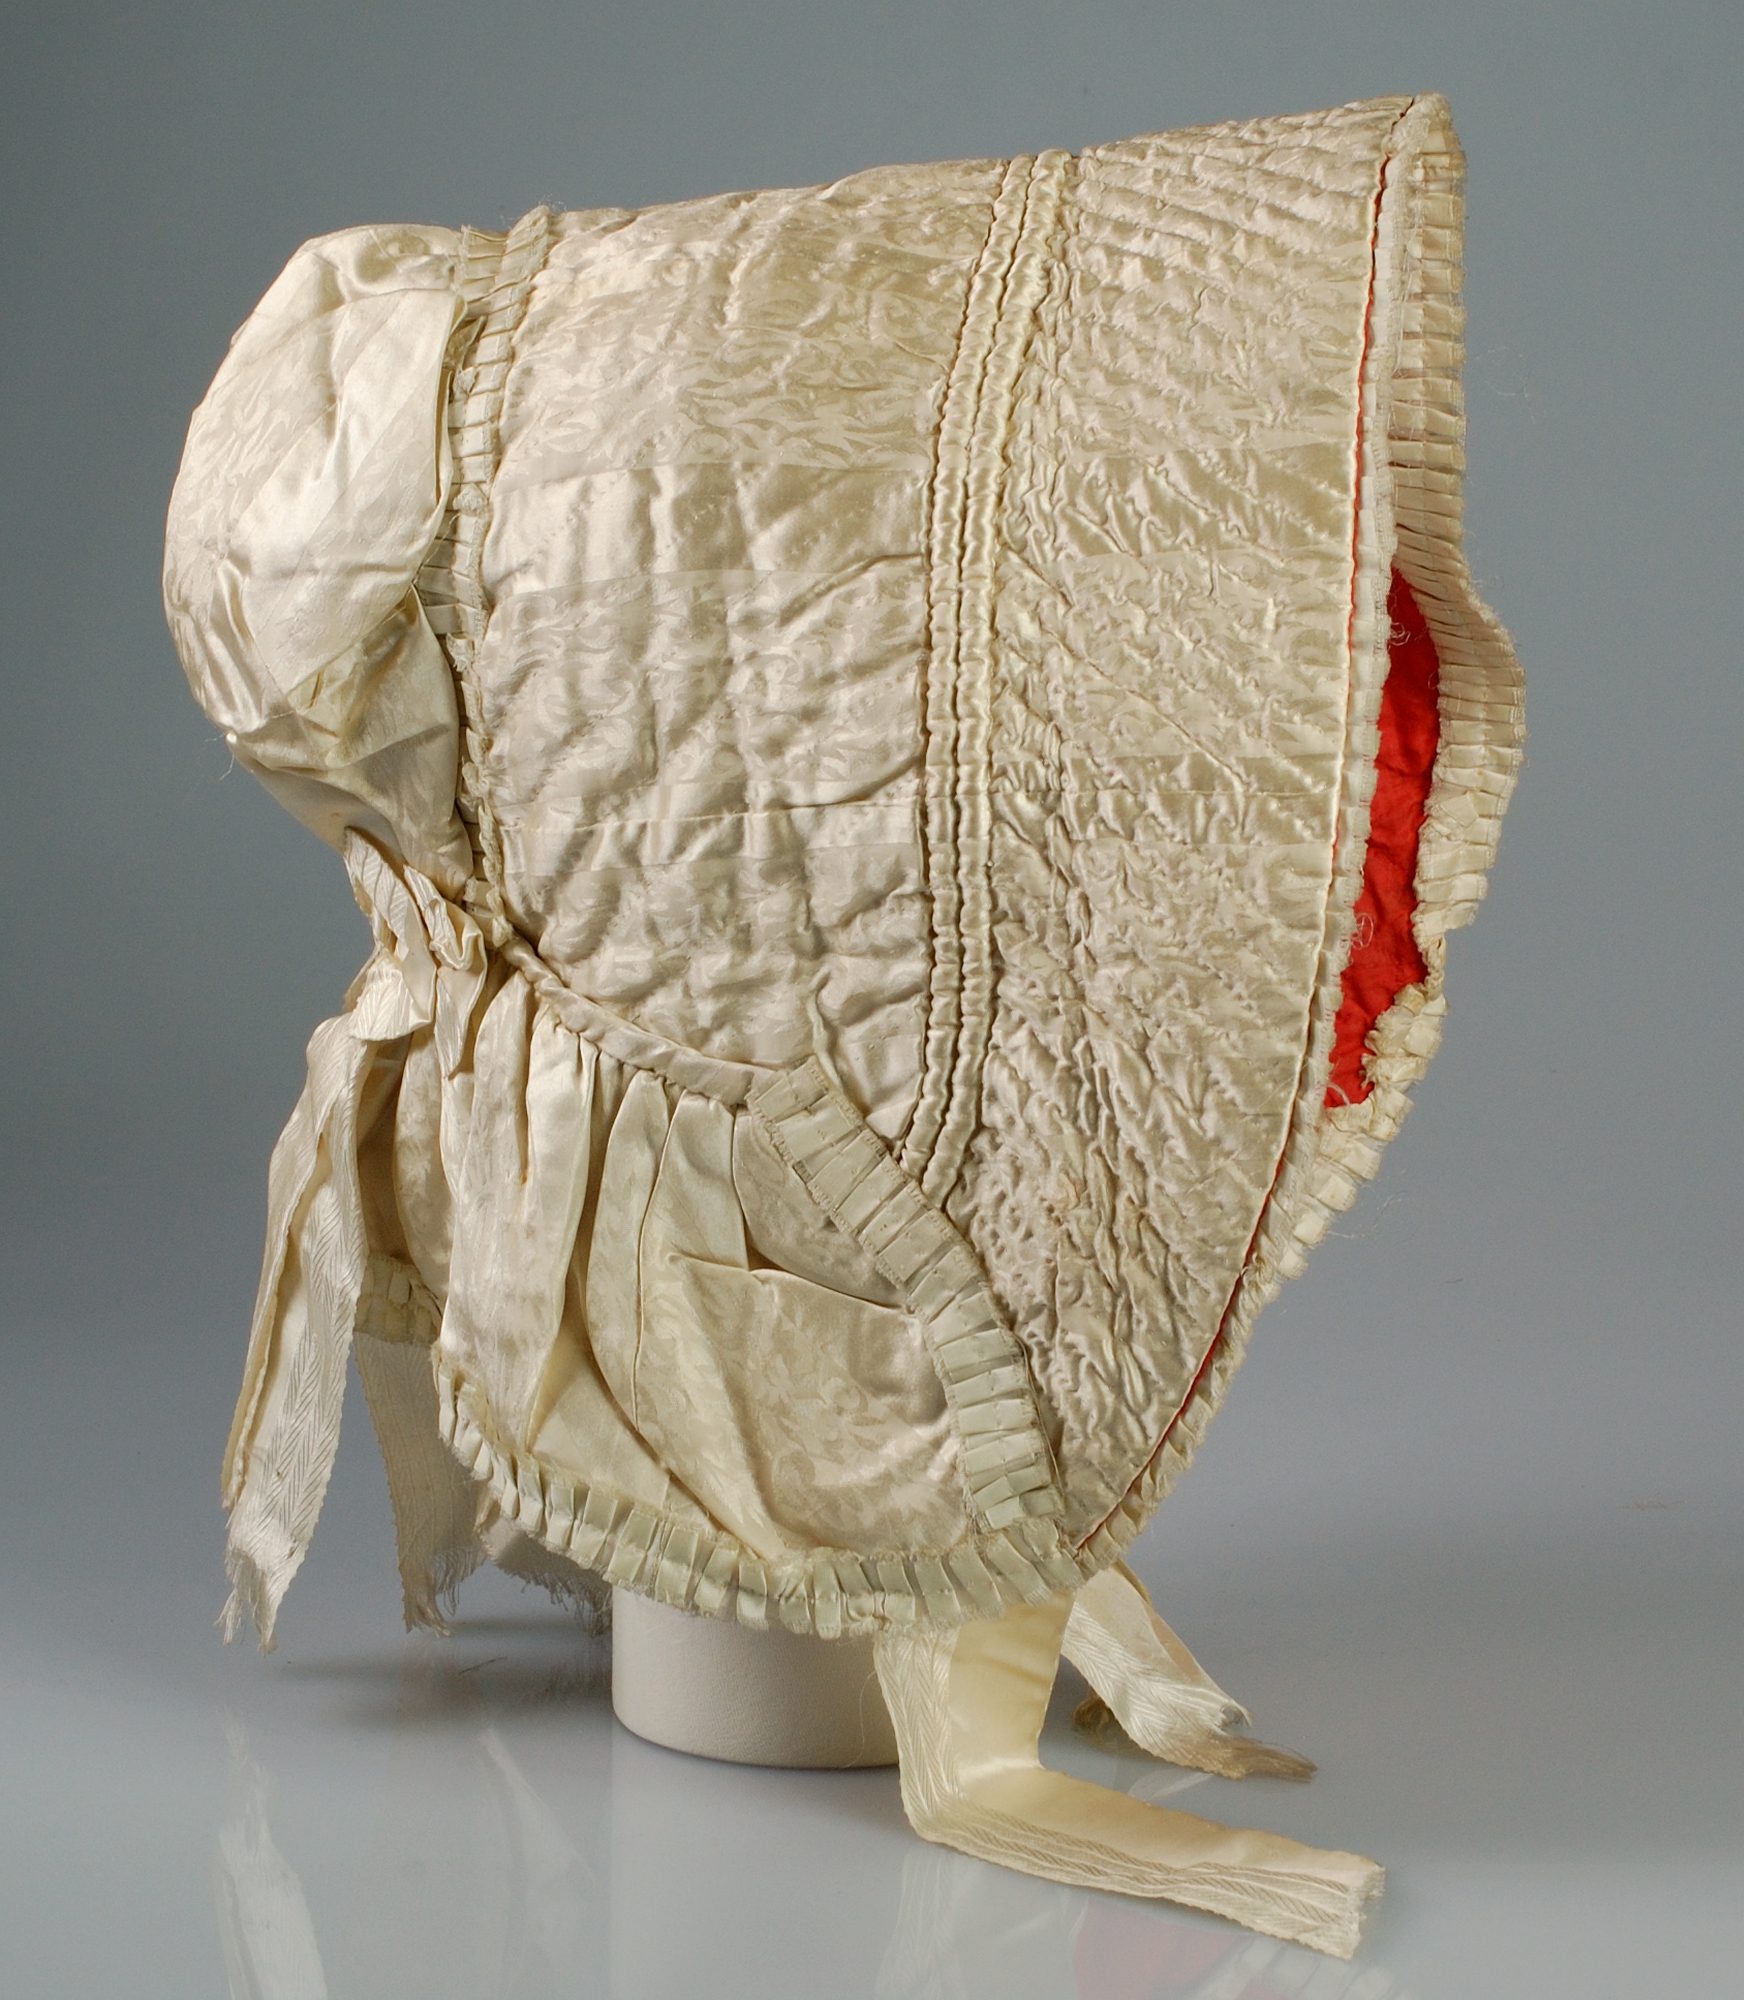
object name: bonnet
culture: american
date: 1835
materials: silk